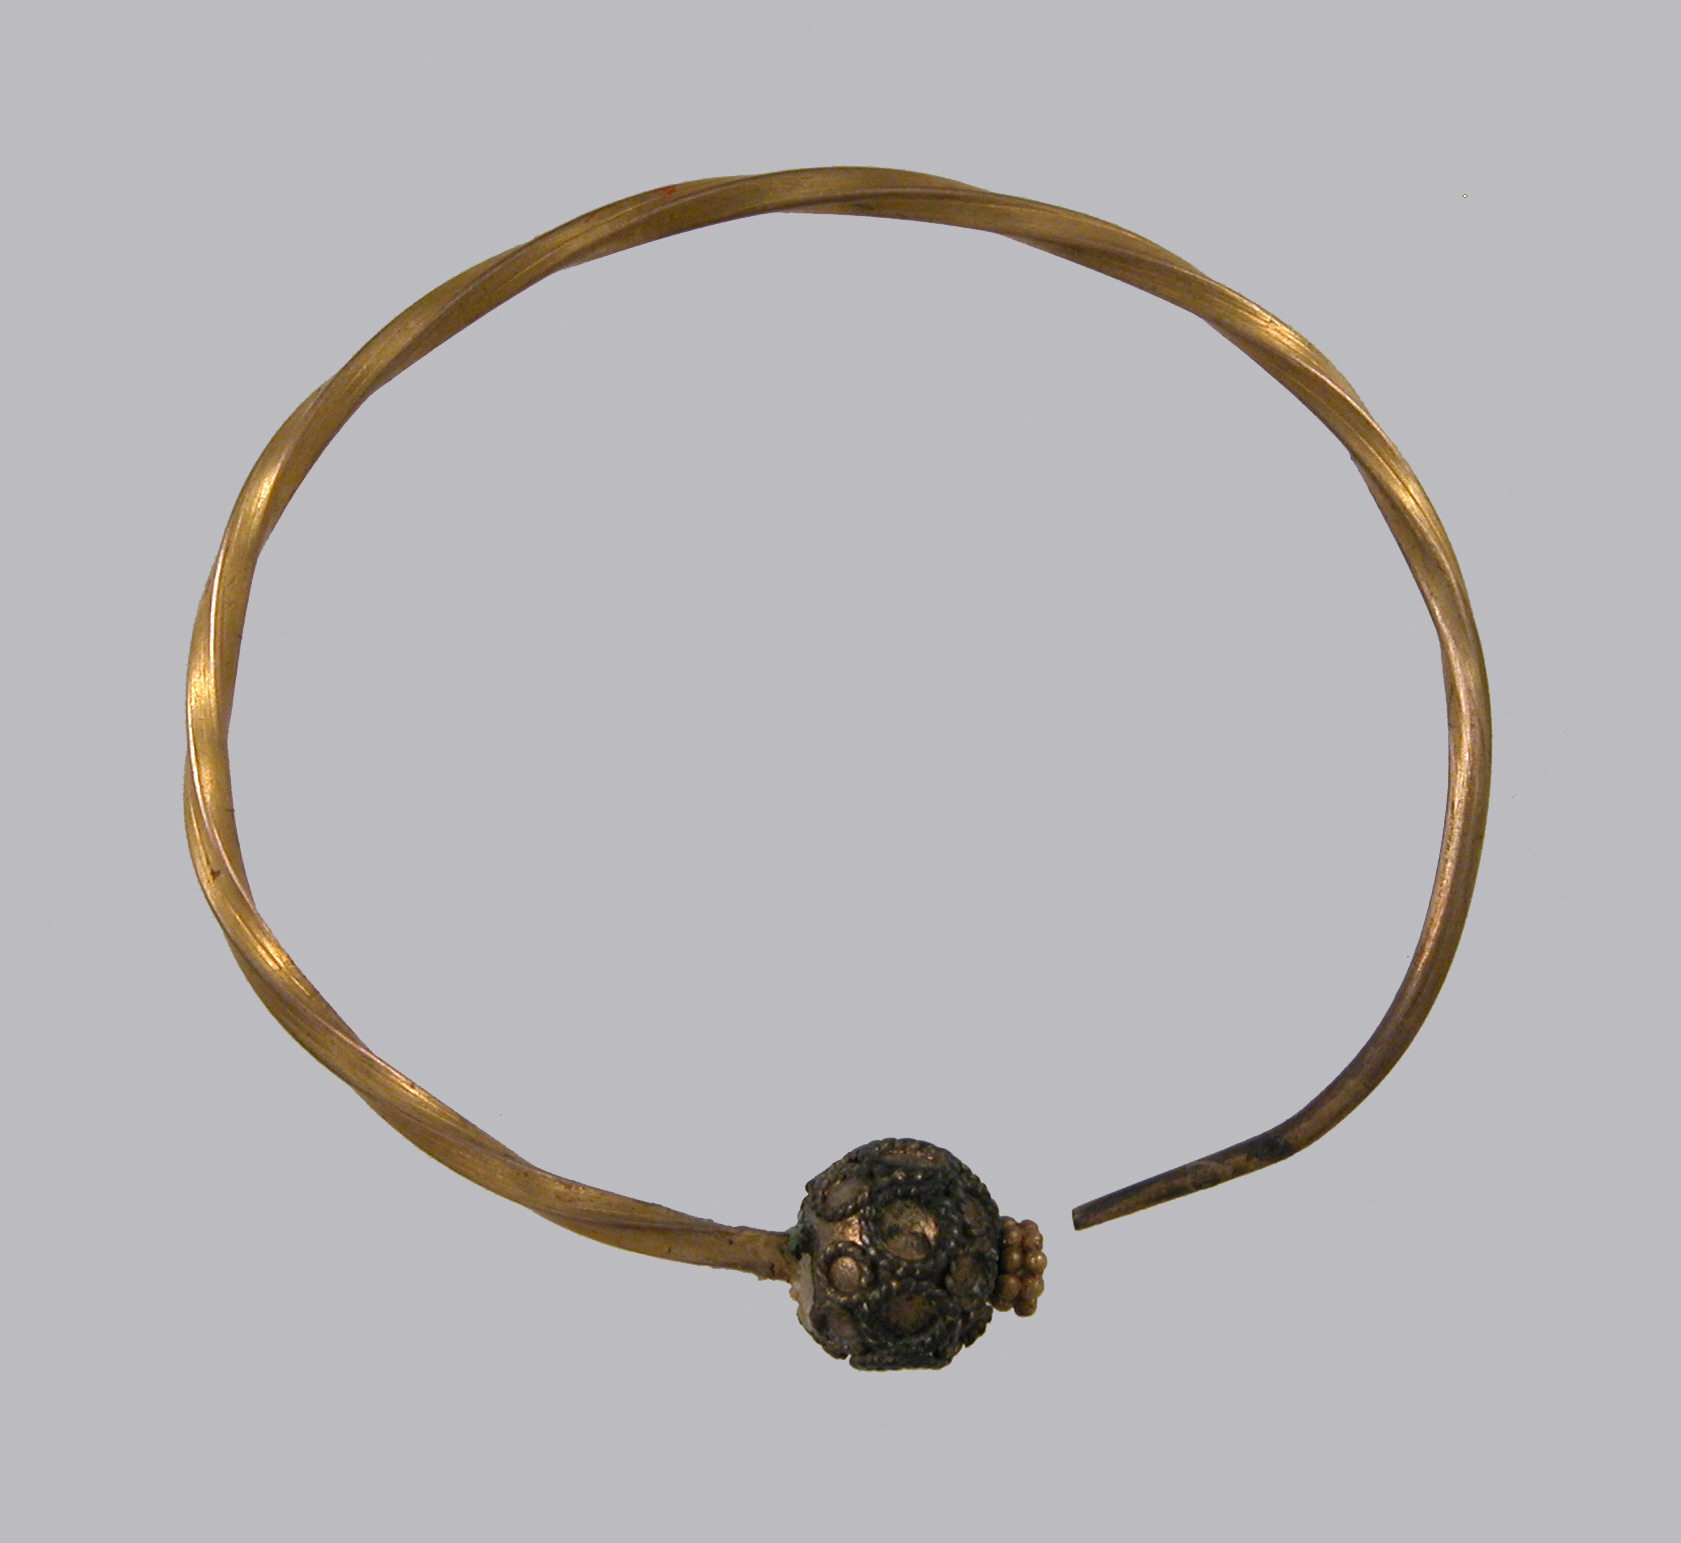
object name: earring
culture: frankish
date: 501-700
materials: gold, metal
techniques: filigree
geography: northern france